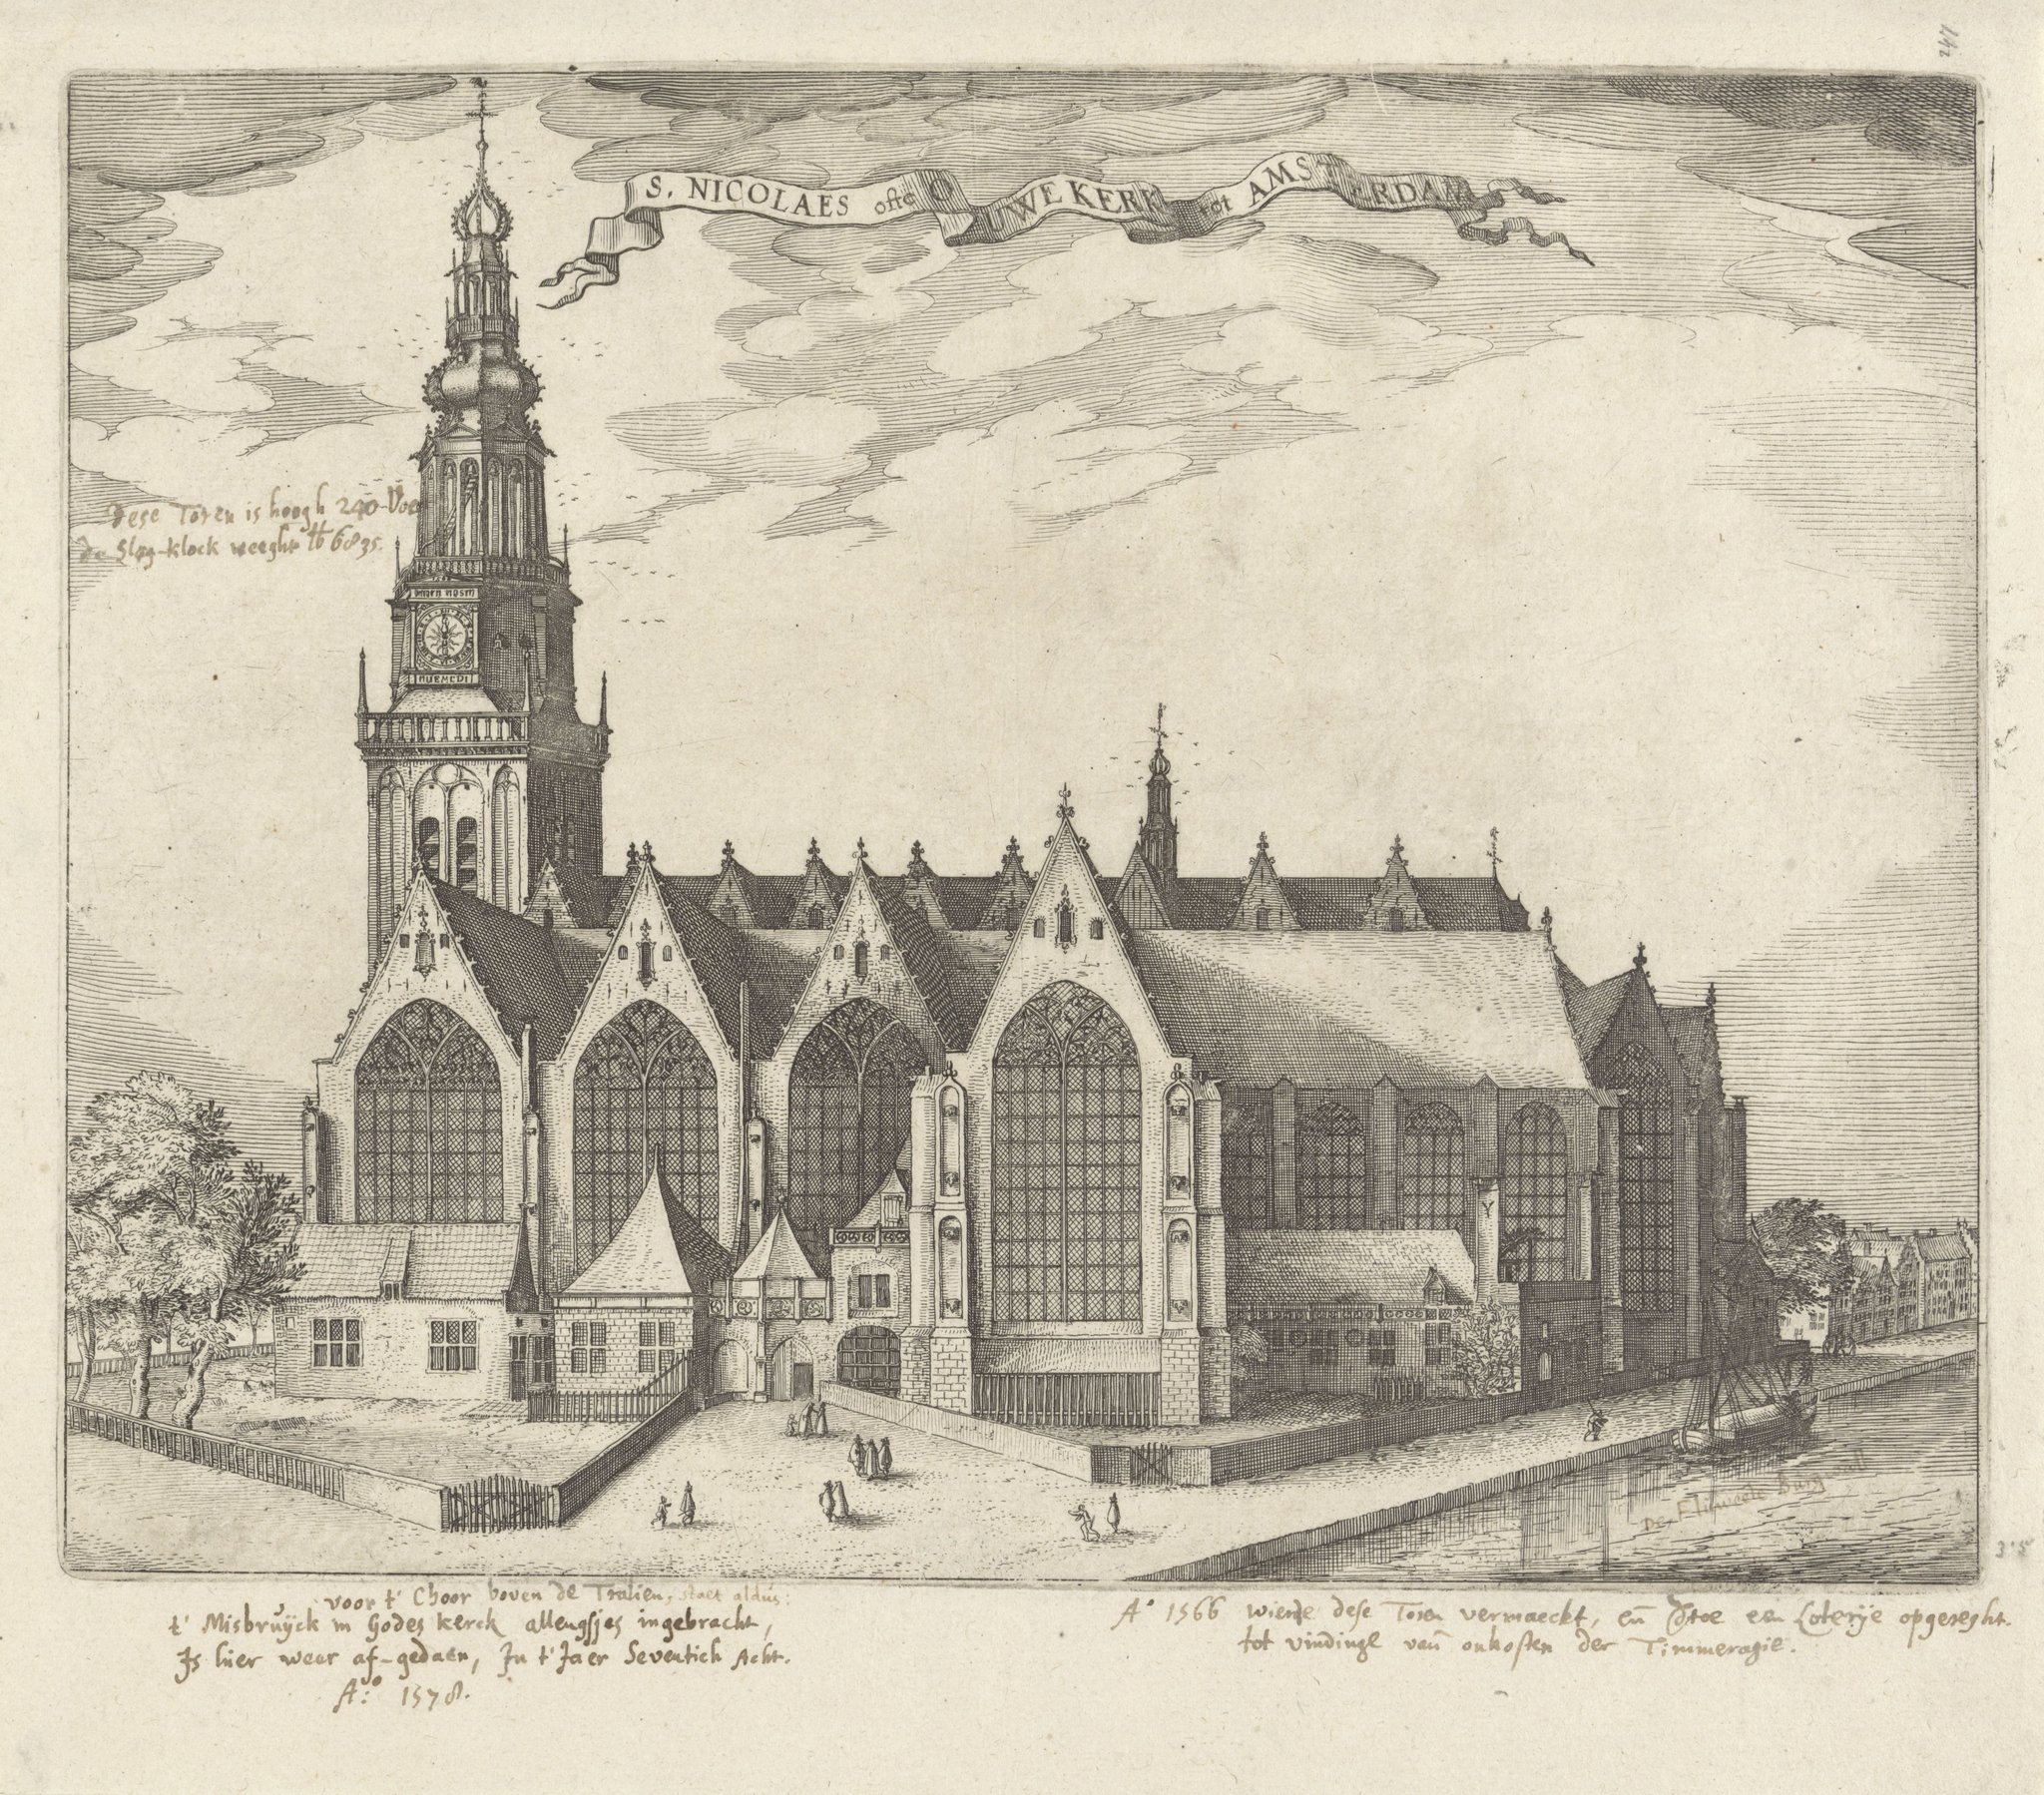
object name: print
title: S. Nicolaes ofte Ouwe Kerk tot Amsterdam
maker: claes jansz. visscher (ii)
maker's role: draughtsman, print maker, publisher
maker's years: 1586-1652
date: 1601-1612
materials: ink, paper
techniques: engraving, etching, pen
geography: amsterdam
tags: church (exterior)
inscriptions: inscription: ‘Dese toren is hoogh 240 Voet / de Slag-klock weeght (...) Timmerafie.’, collector's mark: Lugt 2228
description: Met enige aantekeningen van burgemeester Schaep. Deze prent komt ook voor in enkele exemplaren van: Guicciardini, Lodovico. Beschryvinghe van alle de Neder-landen, anderssins ghenoemt Neder-Duytslandt (…). Amsterdam: Willem Janszoon Blaeu, 1612. En in enkele exemplaren van latere uitgaven van deze publicatie, uitgegeven door Blaeu (1613) en Johannes Janssonius (1624, 1625, 1646 en 1648). Zie ook RP-P-1880-A-3837.